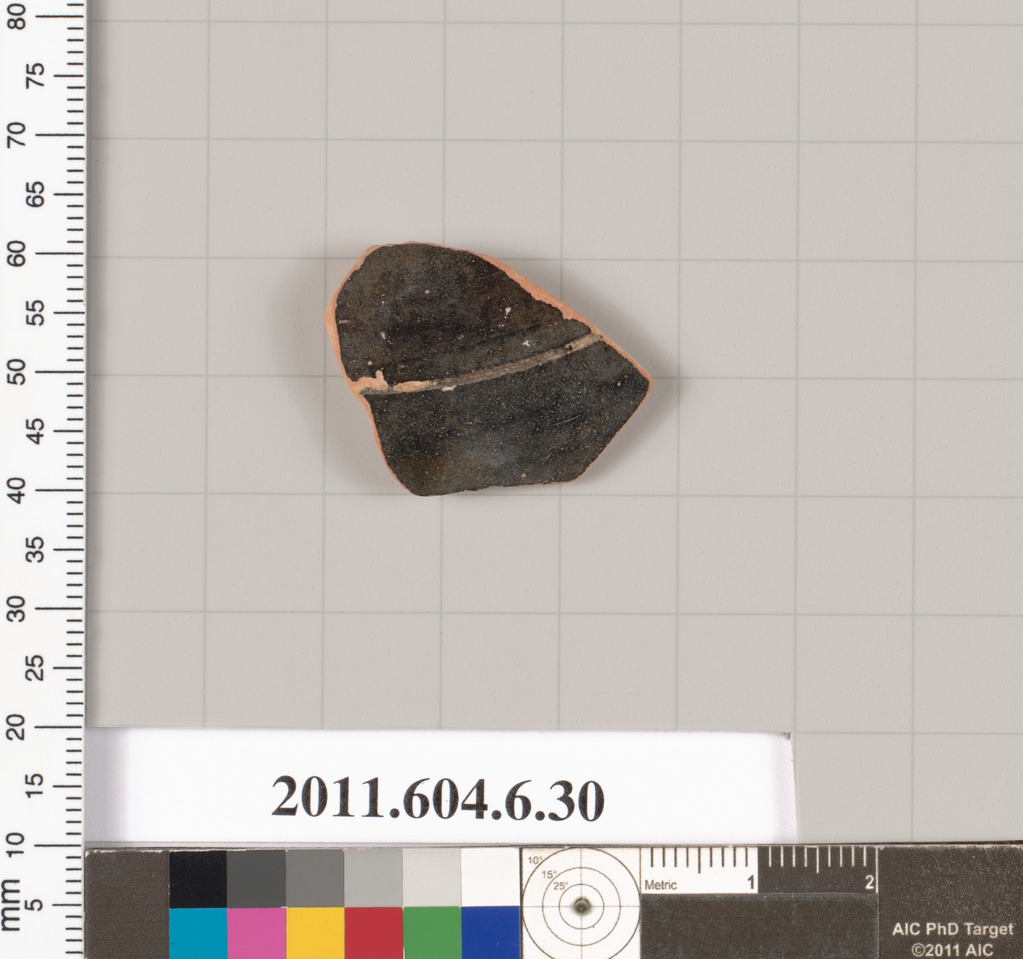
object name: plate or bowl fragment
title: Terracotta fragment of a bowl or plate?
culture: greek, attic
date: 375-351 BCE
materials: terracotta